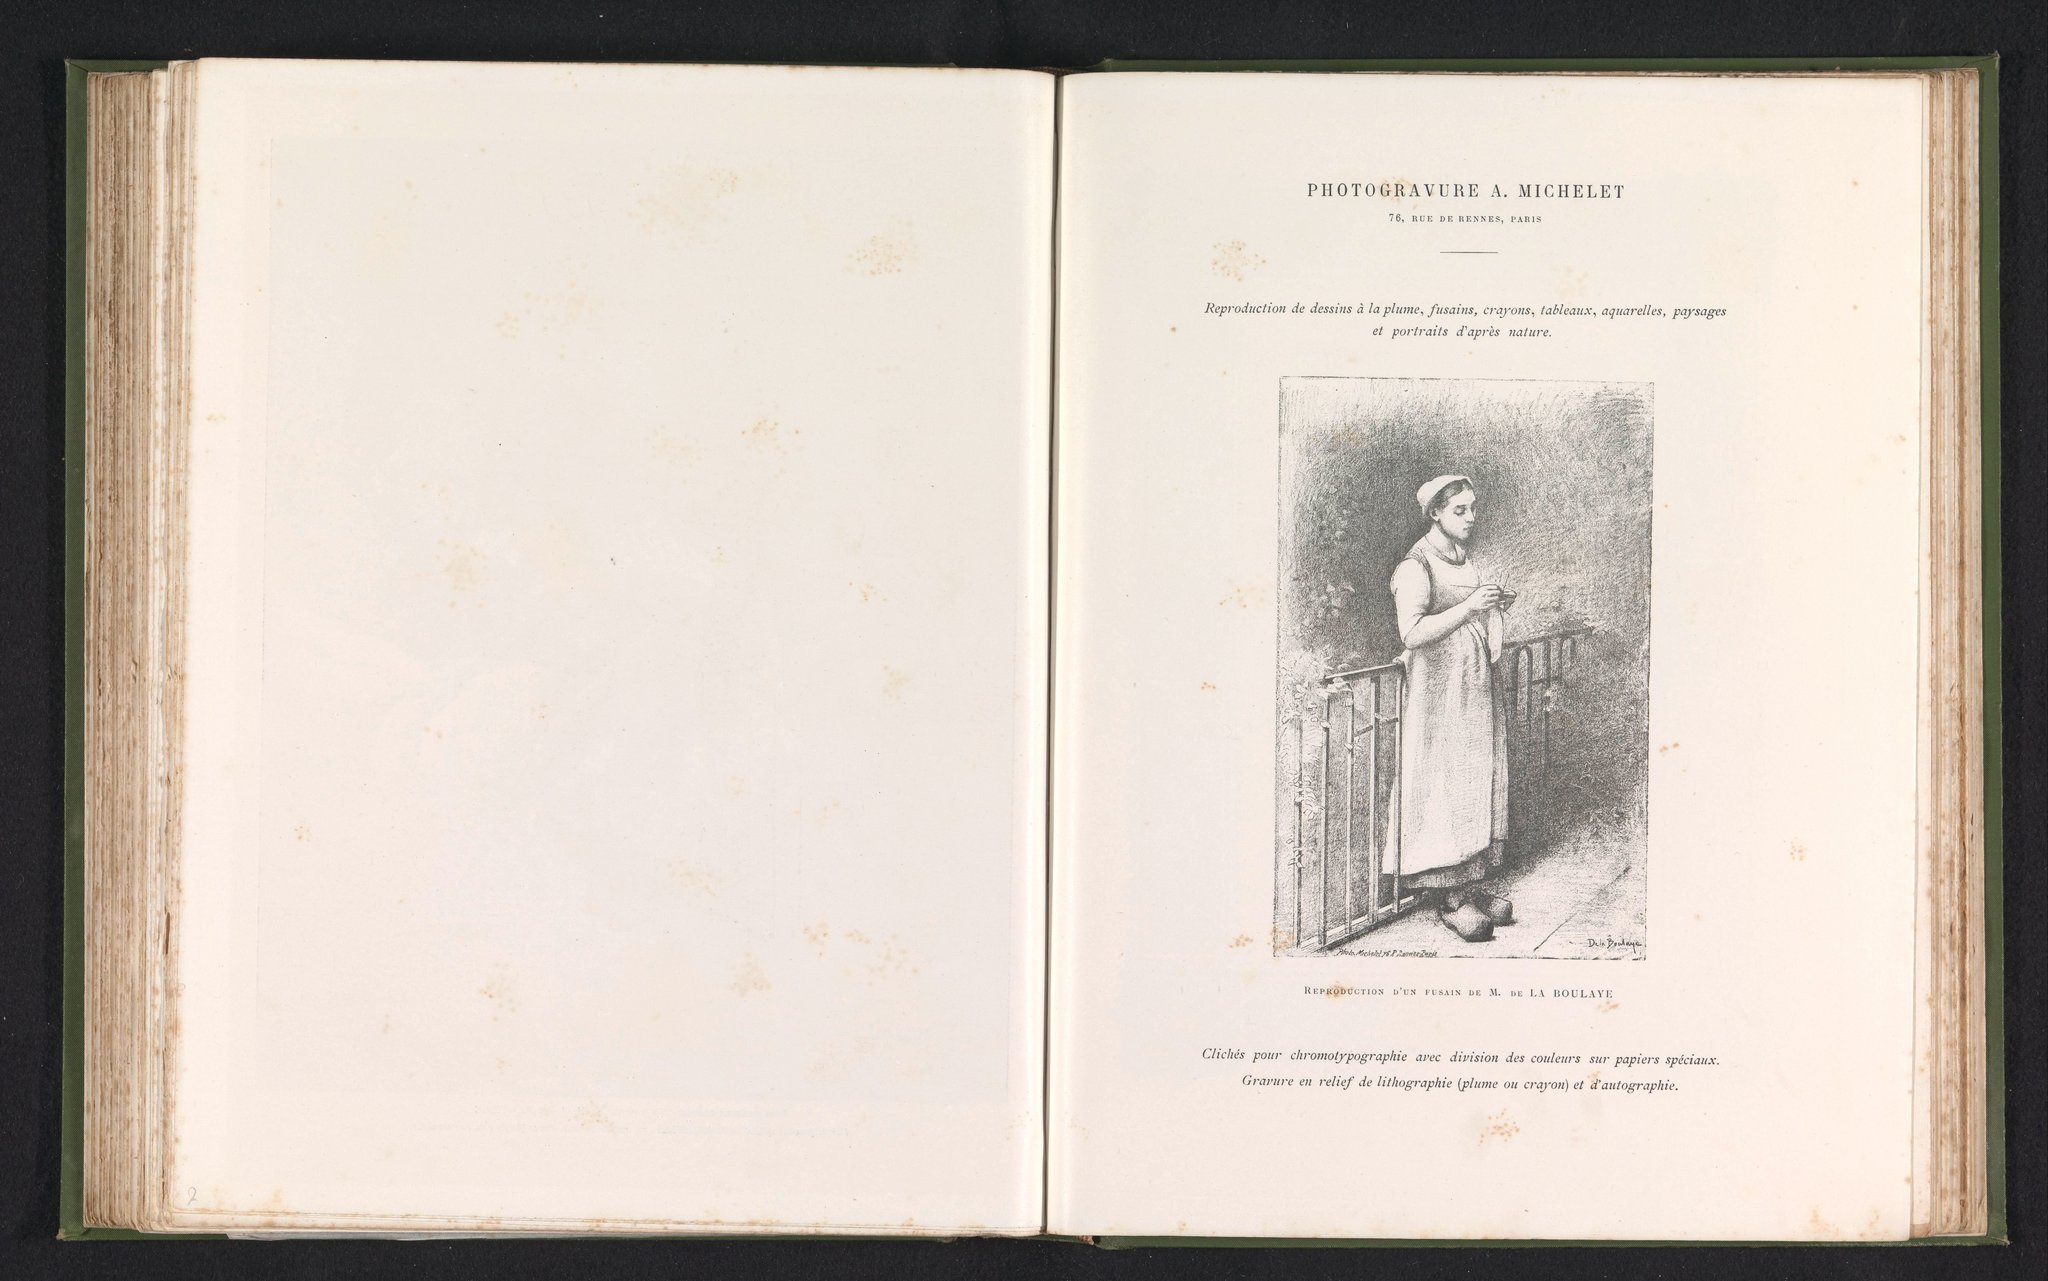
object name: reproduction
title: Fotoreproductie van een tekening, voorstellende een breiend meisje voor een hek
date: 1871-1881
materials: paper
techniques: photolithography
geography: paris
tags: adolescent, young woman, maiden, fence, wall, paling, knitting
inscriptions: inscription: ‘photogravure A. Michelet 7, Rue de Rennes, Paris Reproduction de dessins à la plume (...) Gravure en relief de lithographie (plume ou crayon) et d'autographie.’